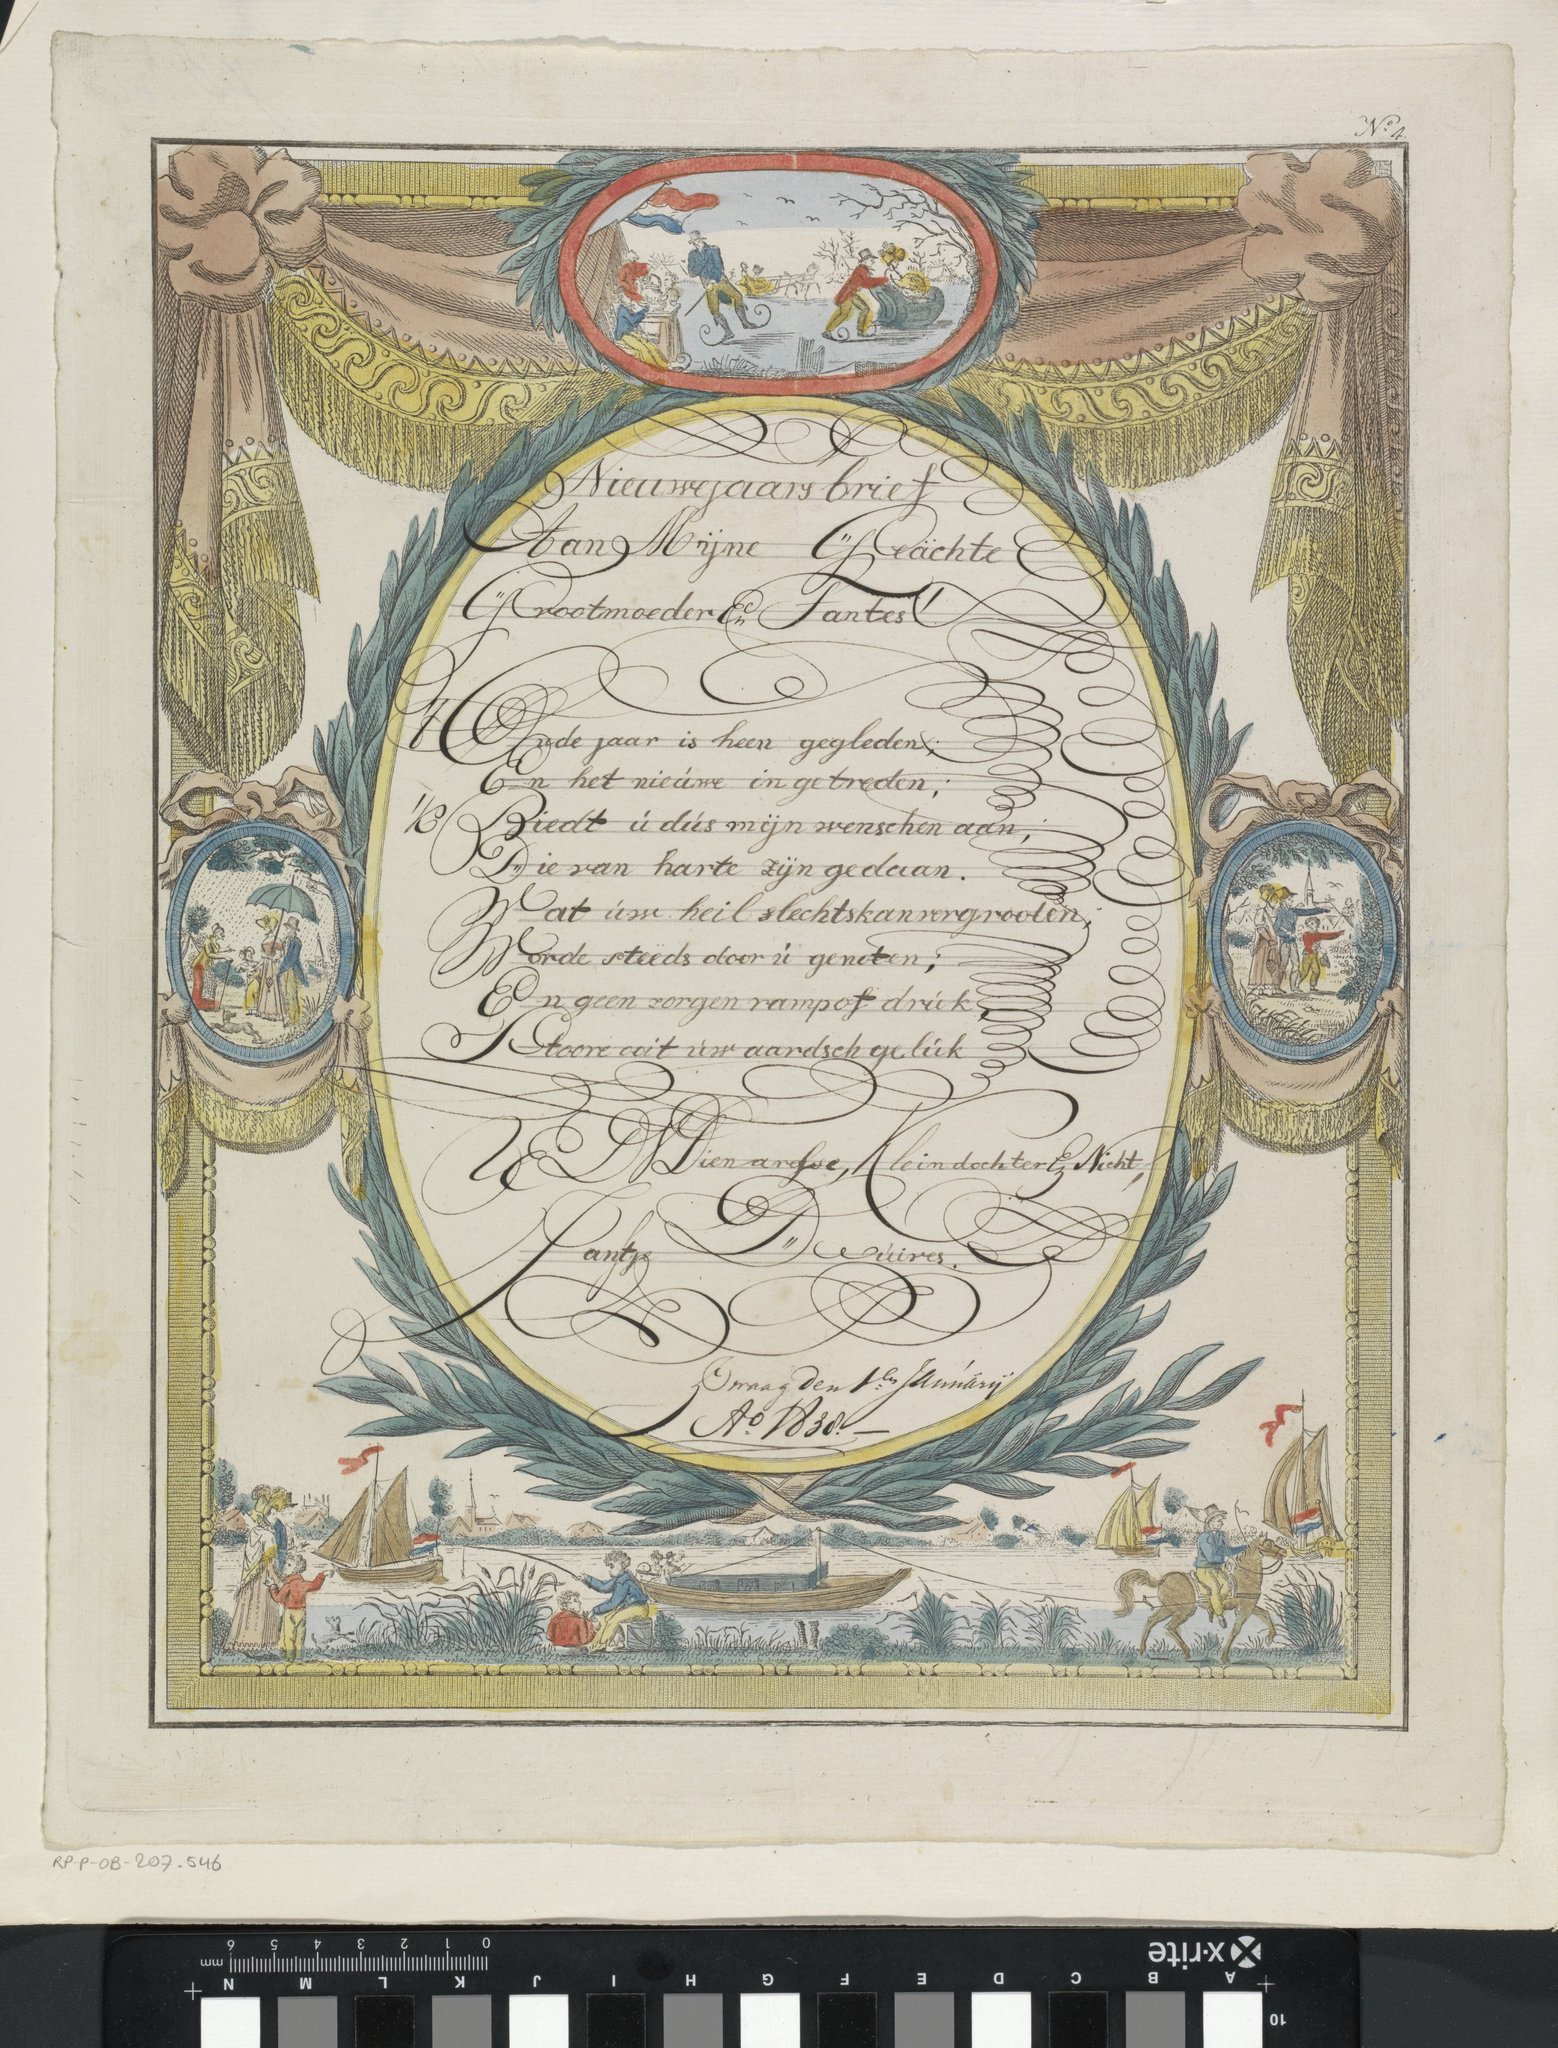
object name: popular print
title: Wensbrief met trekschuit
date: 1792-1847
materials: ink, paper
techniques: calligraphy, colour, etching, pen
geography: netherlands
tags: human types, tow-boat, towing-barge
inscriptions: inscription: ‘Nieuwejaars brief / Aan mijne geächte / Grootmoeder en tantes! / 't Oude jaar is heen gegleden ...’, collector's mark: Lugt 2760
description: Wensbrief met beschreven cartouche binnen een decoratief kader met een voorstelling van een rivier met een trekschuit. In kleine medaillons voorstellingen van schaatsende en sleeënde mensen, mensen in de regen en een wandelend gezin. Handgeschreven bericht in kalligrafie (Nieuwjaarsbrief) door Jantje Duives aan zijn grootmoeder en tantes. Genummerd rechtsboven: No. 4.